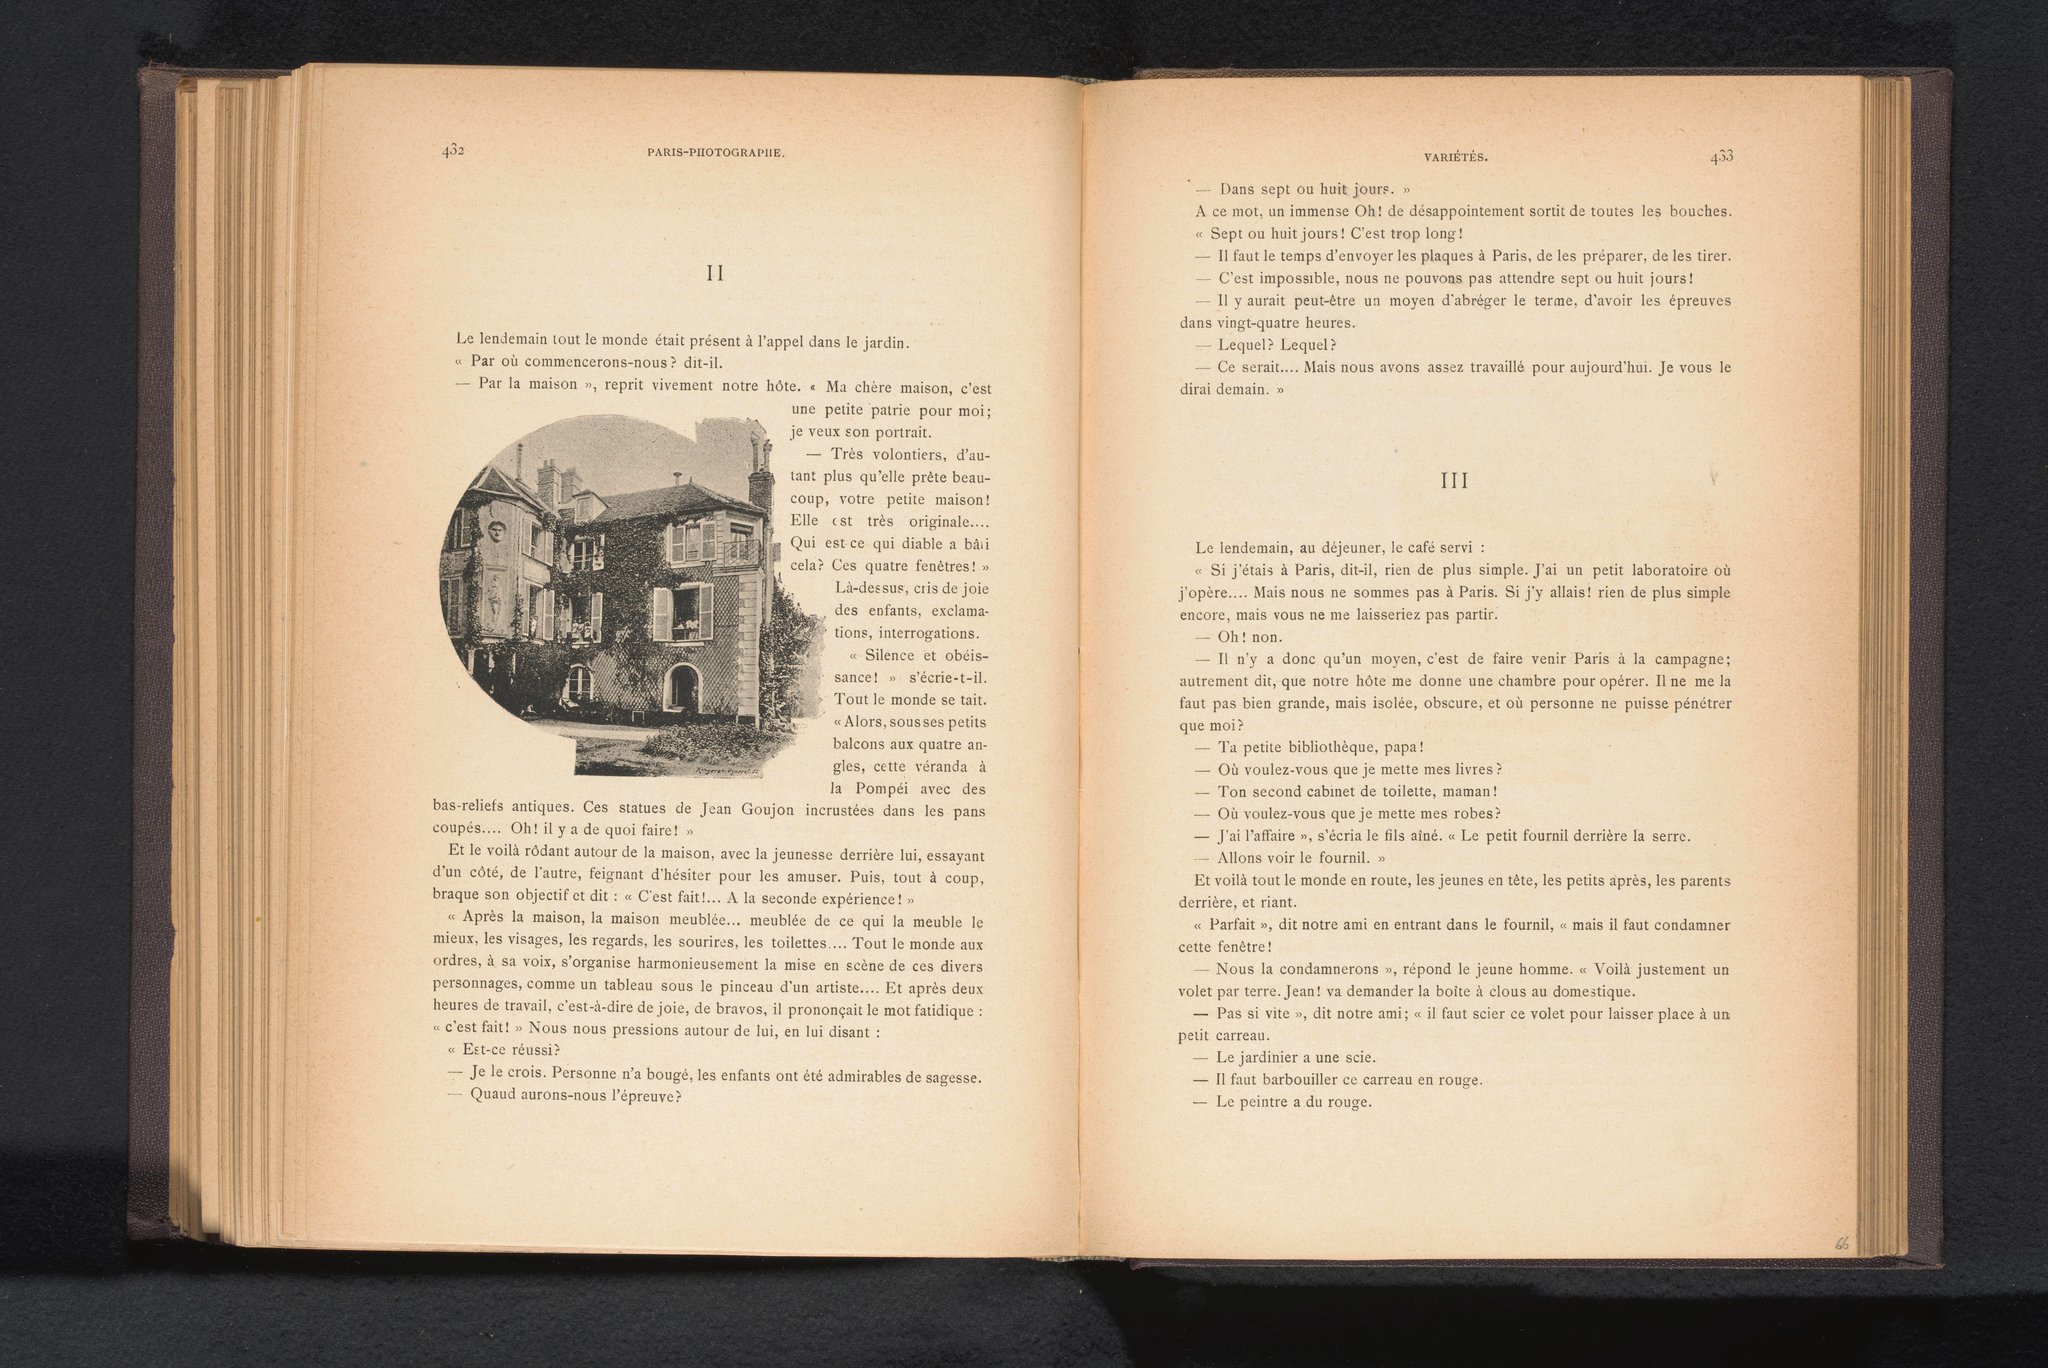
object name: photomechanical print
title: Gezicht op een huis in Frankrijk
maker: Anonymous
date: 1883-1893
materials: paper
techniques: autotype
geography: france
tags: housing